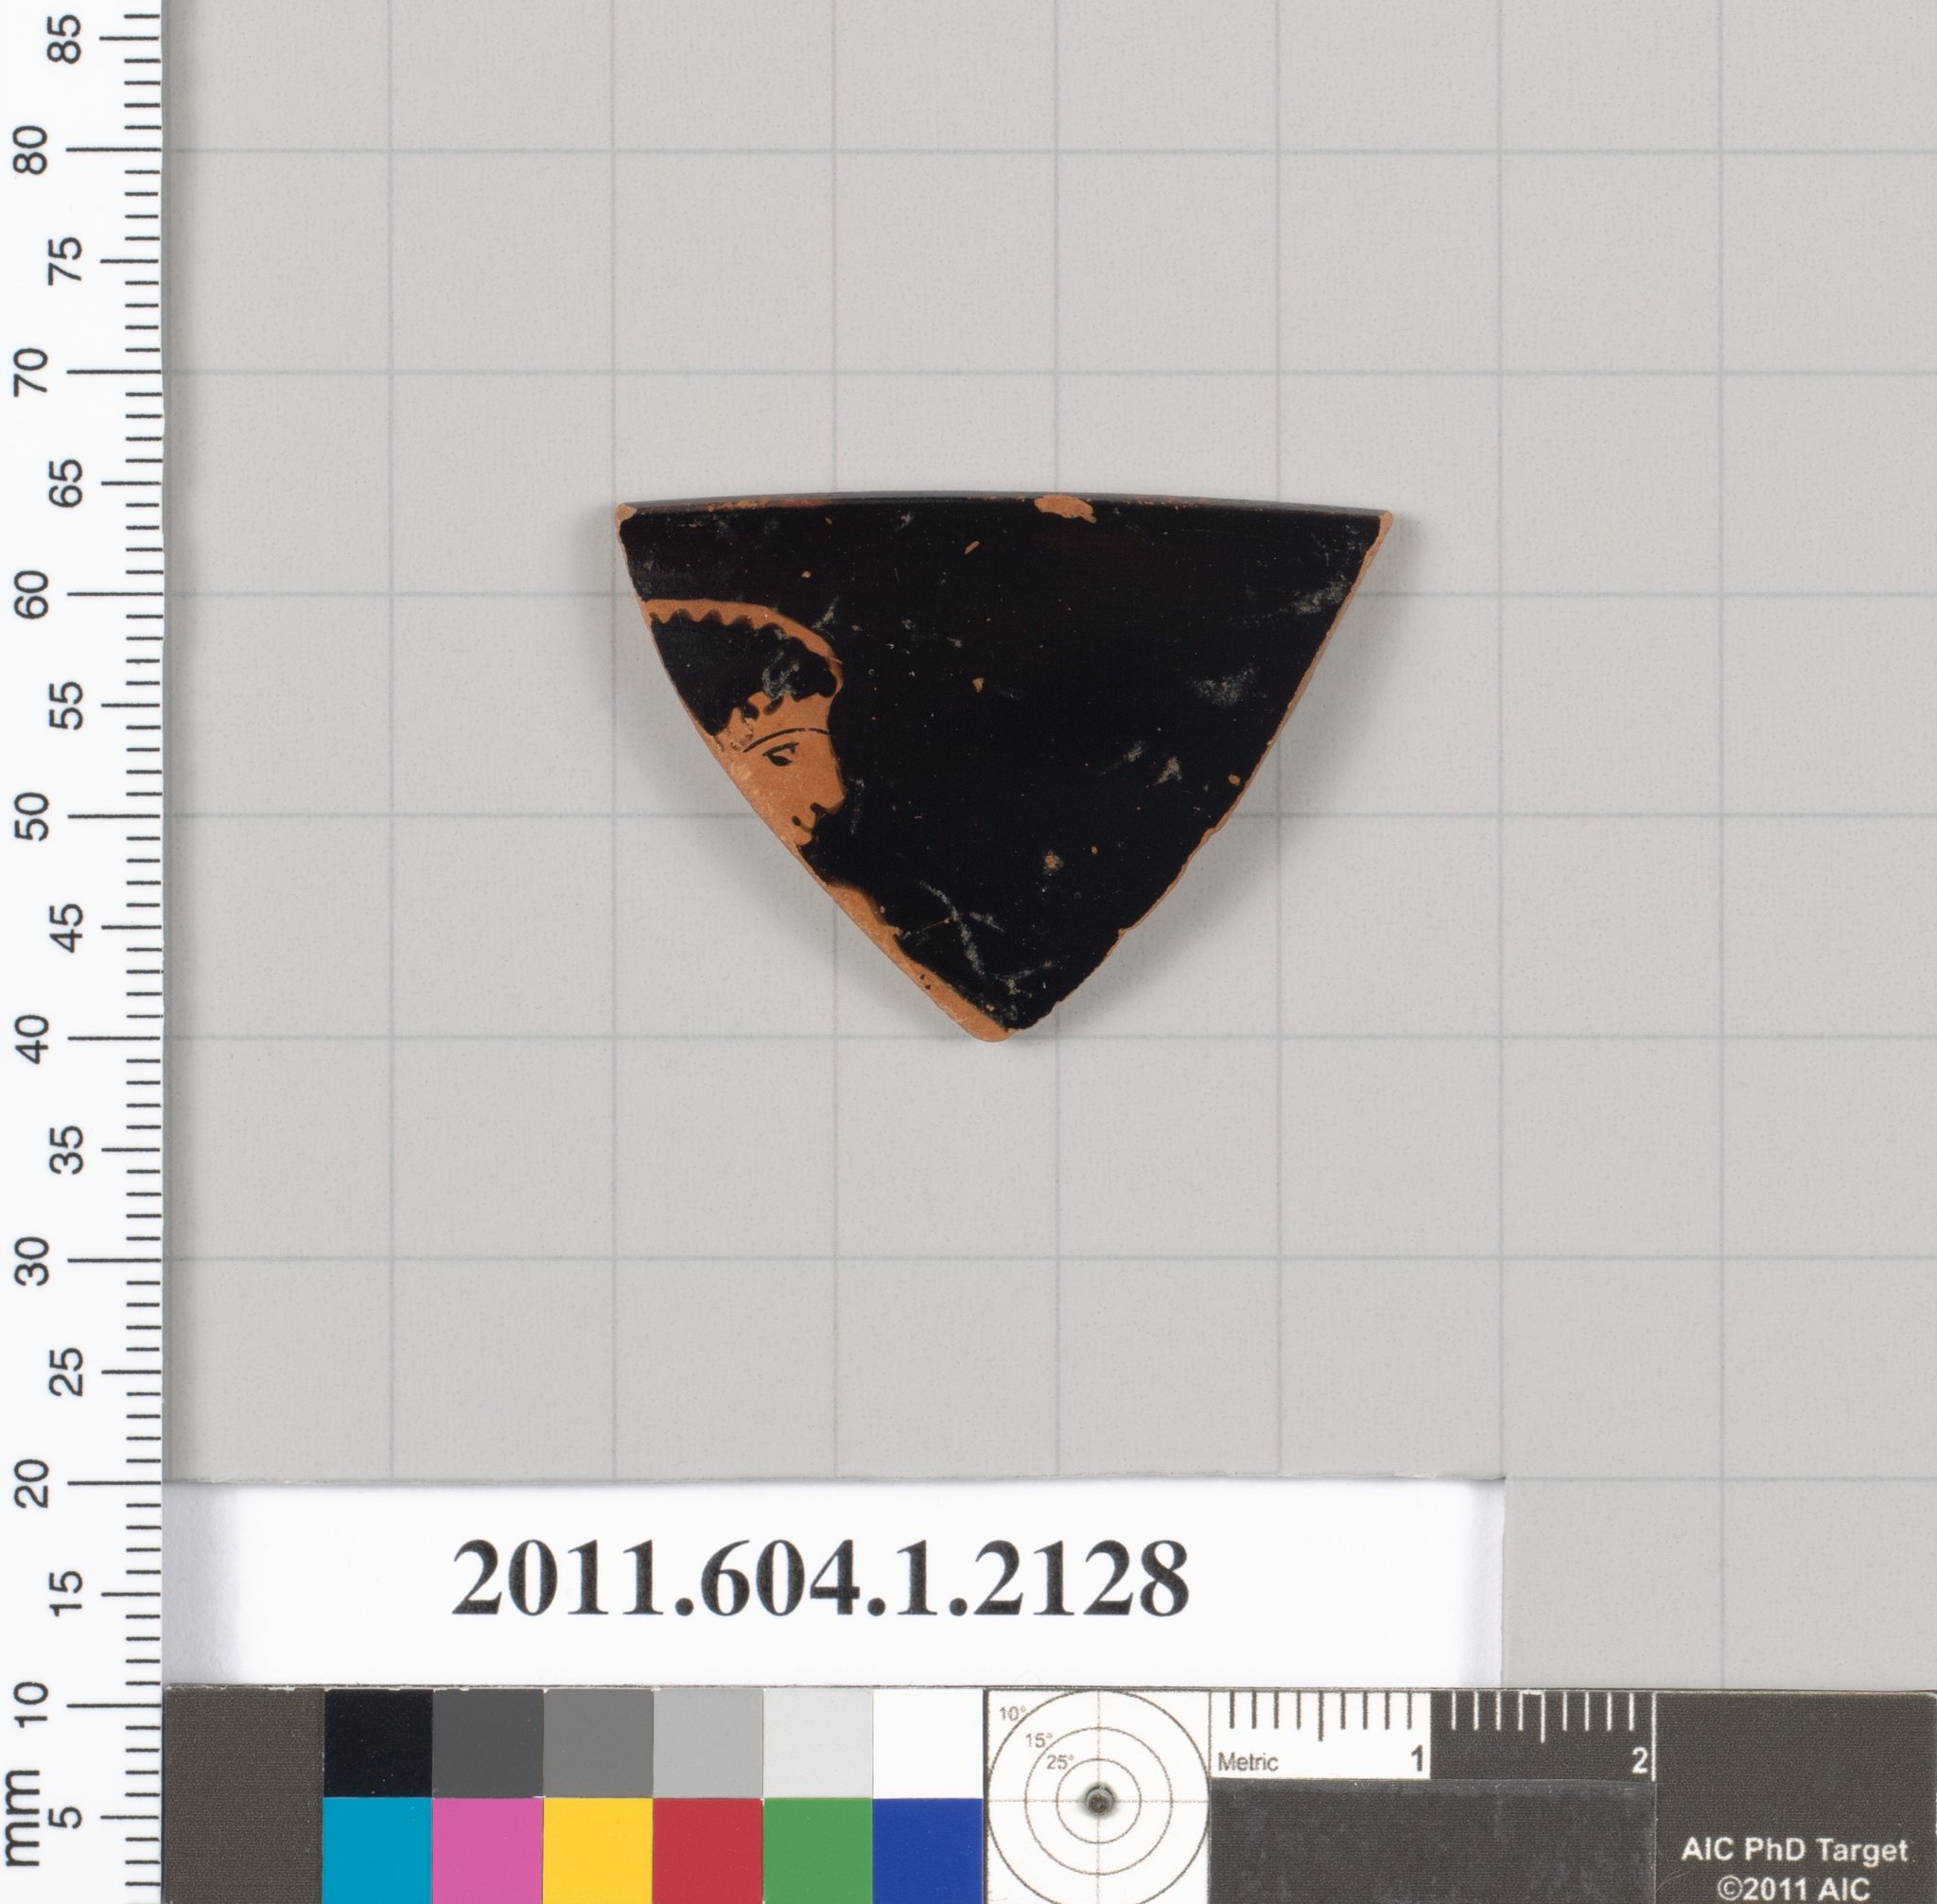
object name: kylix fragment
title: Terracotta rim fragment of a kylix (drinking cup)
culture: greek, attic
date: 460-450 BCE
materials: terracotta